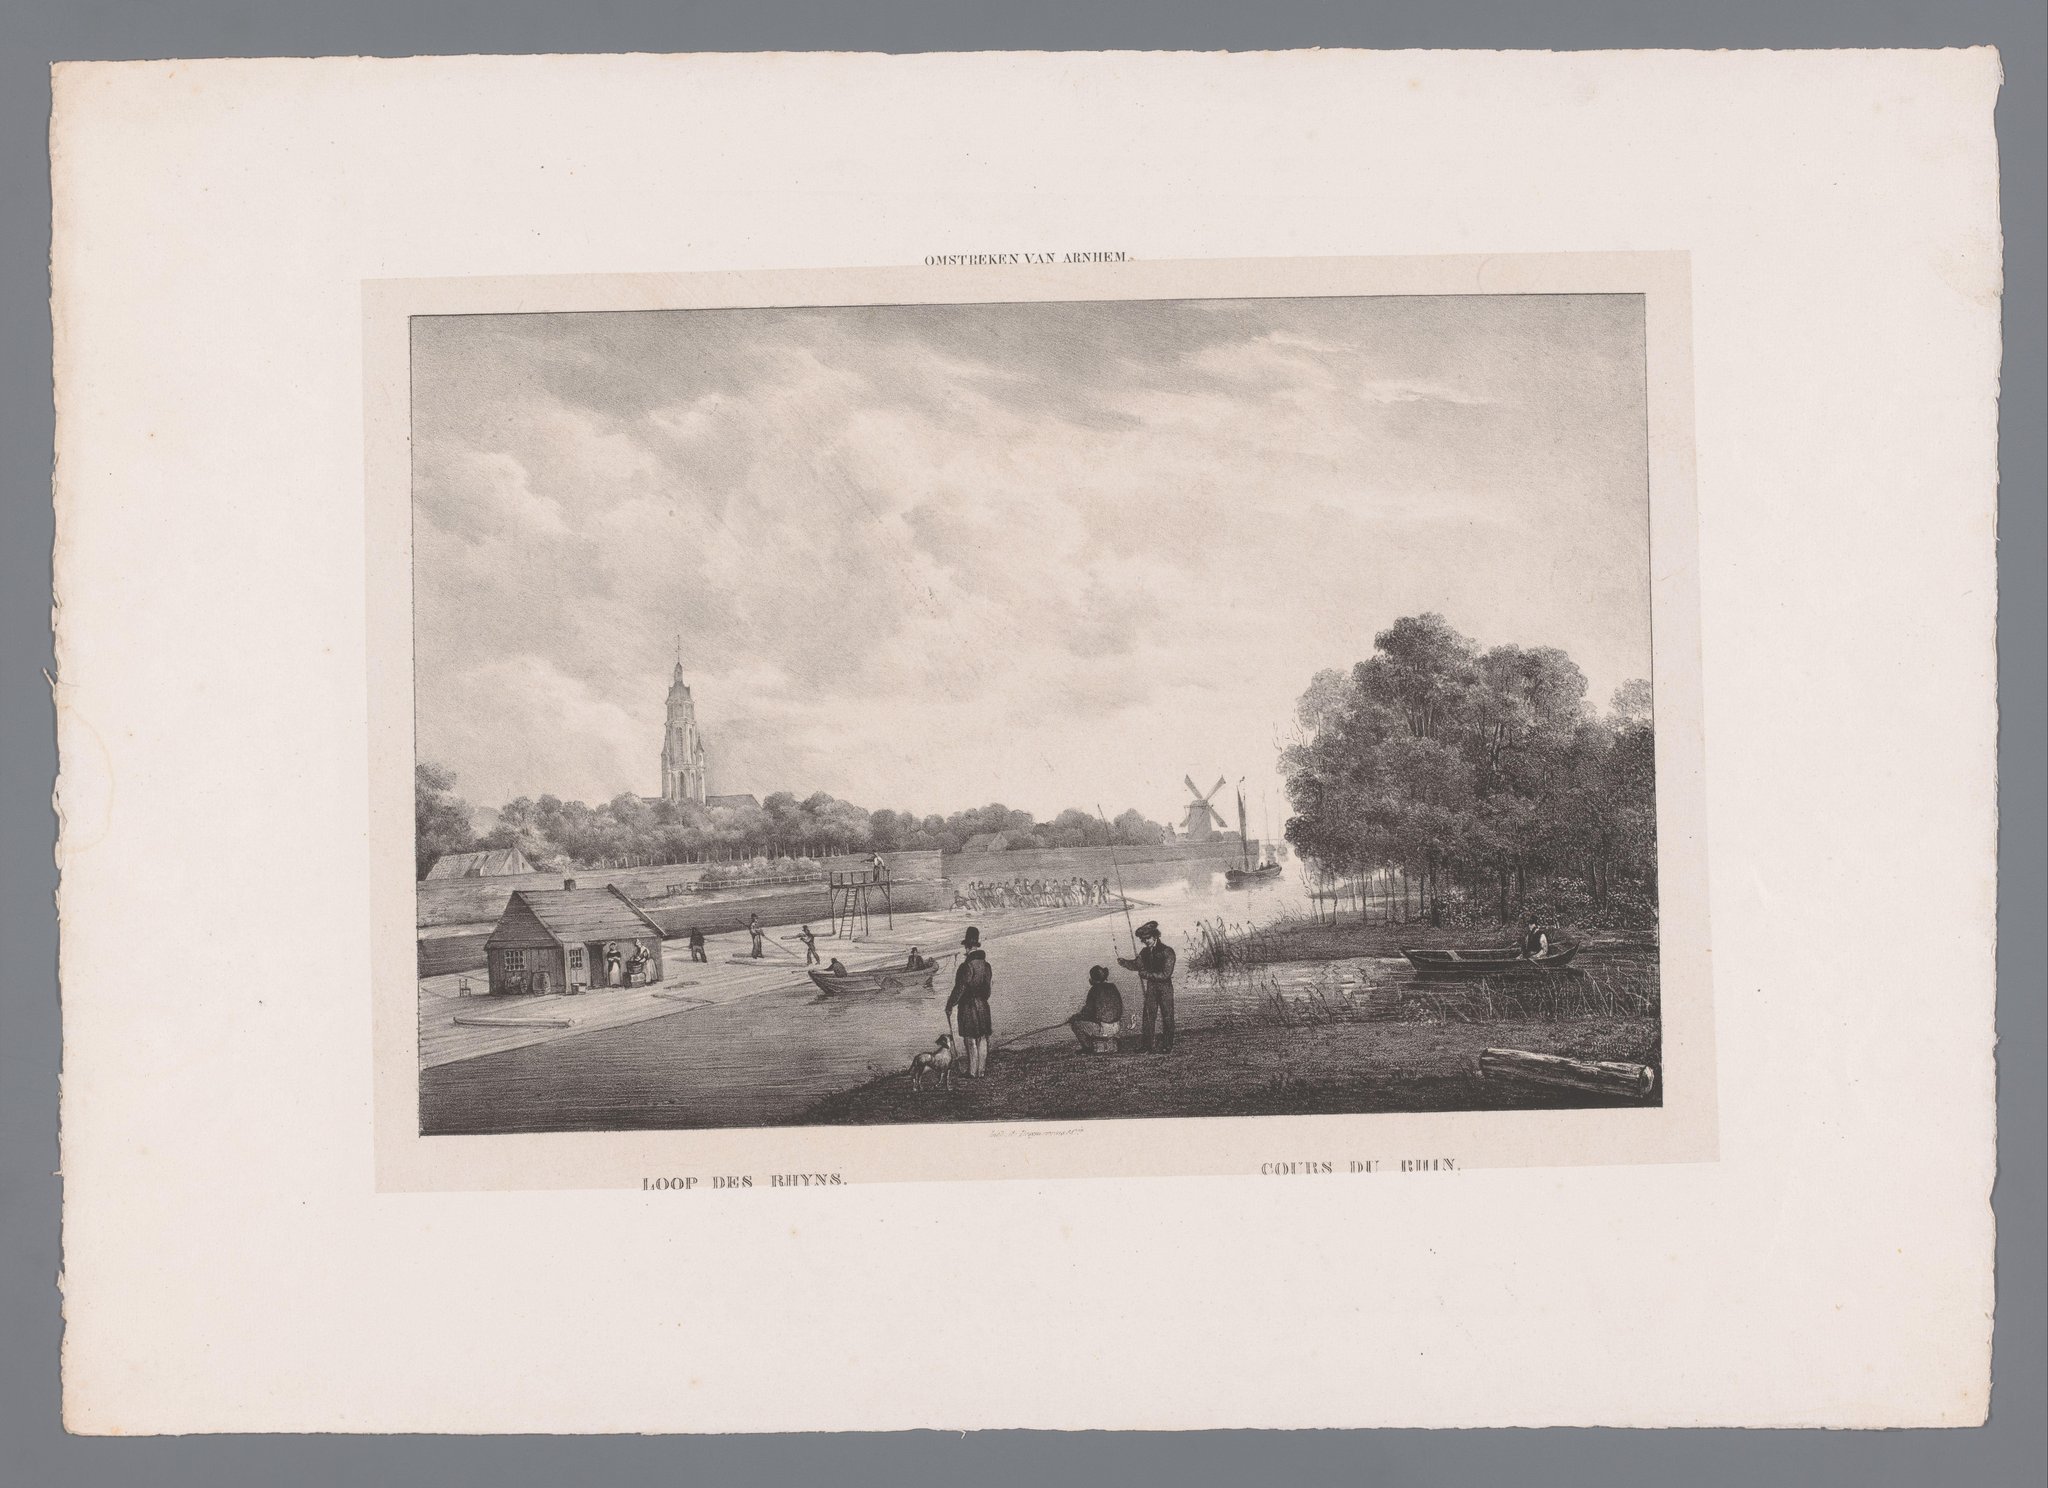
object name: print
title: Omstreken van Arnhem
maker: Anonymous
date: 1827-1907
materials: paper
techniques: lithograph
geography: amsterdam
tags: city-view, and landscape with man-made constructions, church (exterior), windmill in landscape, river (+ landscape with figures, staffage), arnhem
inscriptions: collector's mark: Lugt 2228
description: In het midden van de rivier ligt een groot houten vlot met daarop figuren en een huis. Aan de andere kant van het water zijn stadsmuren te zien, de Eusebiuskerk en een windmolen. Maakt deel uit van een omslag met zes prenten.